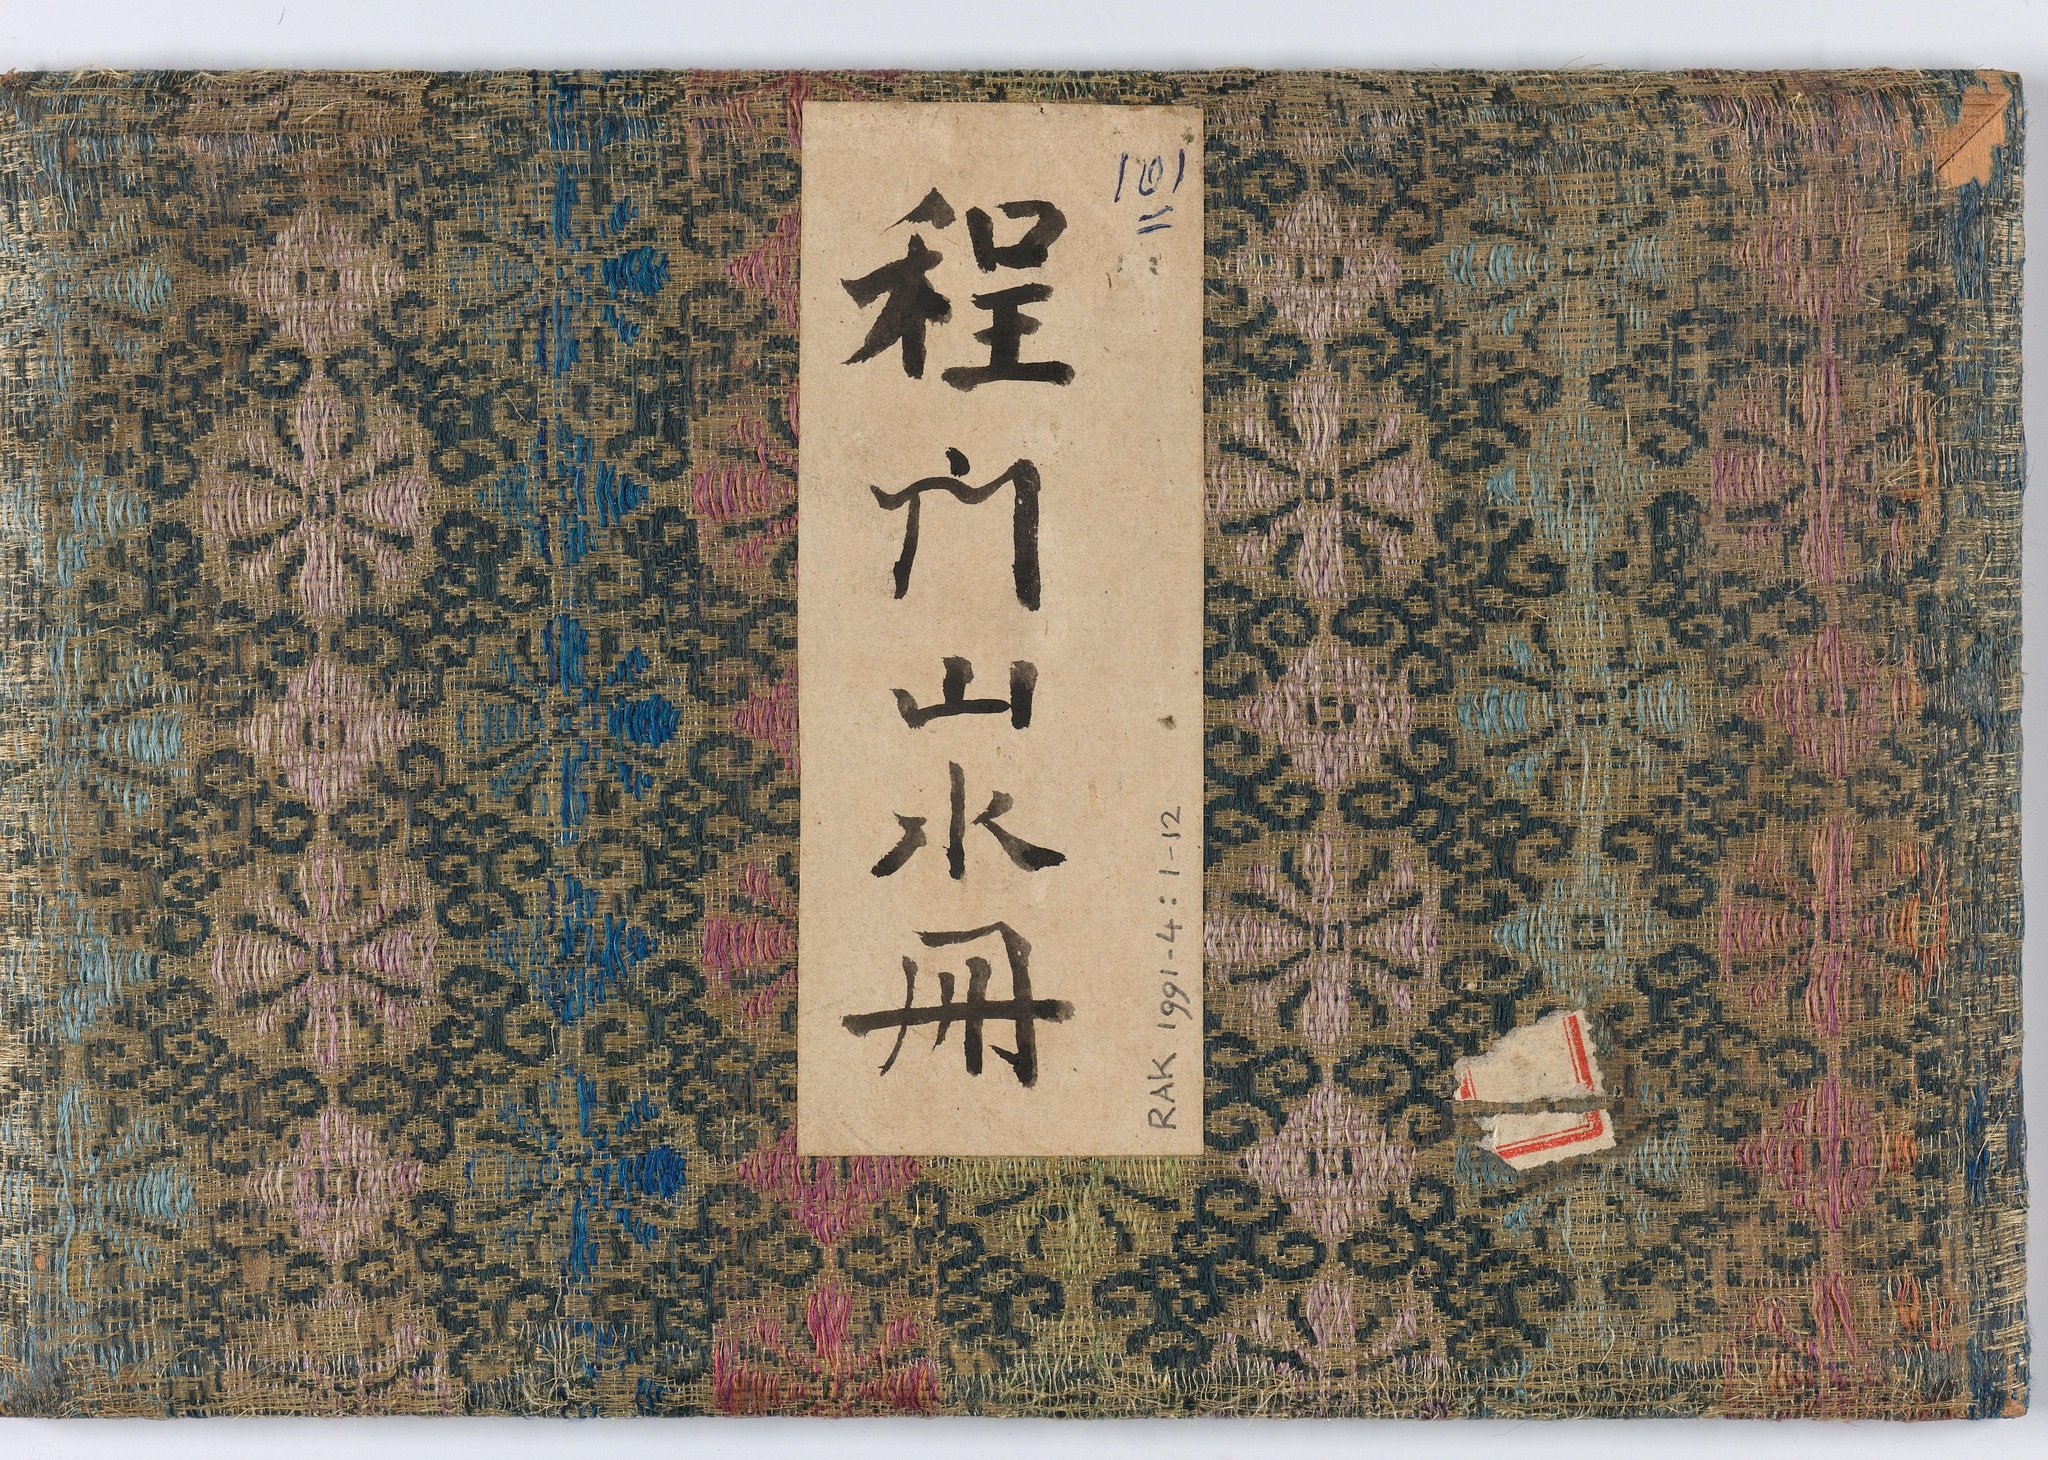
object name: album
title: Album met twaalf bladen met landschappen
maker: cheng men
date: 1850-1900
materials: ink, paper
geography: shexian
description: Album pages with landscapes. Cheng Men. China. Second half of 19th century. Ink and colours on paper. These pages are part of an album of twelve pages, all of them showing landscapes. Cheng Men specialized in painting in small formats. He also worked as a painter of porcelainin the factories of Jingdezhen.